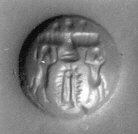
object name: stamp seal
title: Stamp seal (conoid) with cultic scene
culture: assyrian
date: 700-601 BCE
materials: stone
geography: mesopotamia